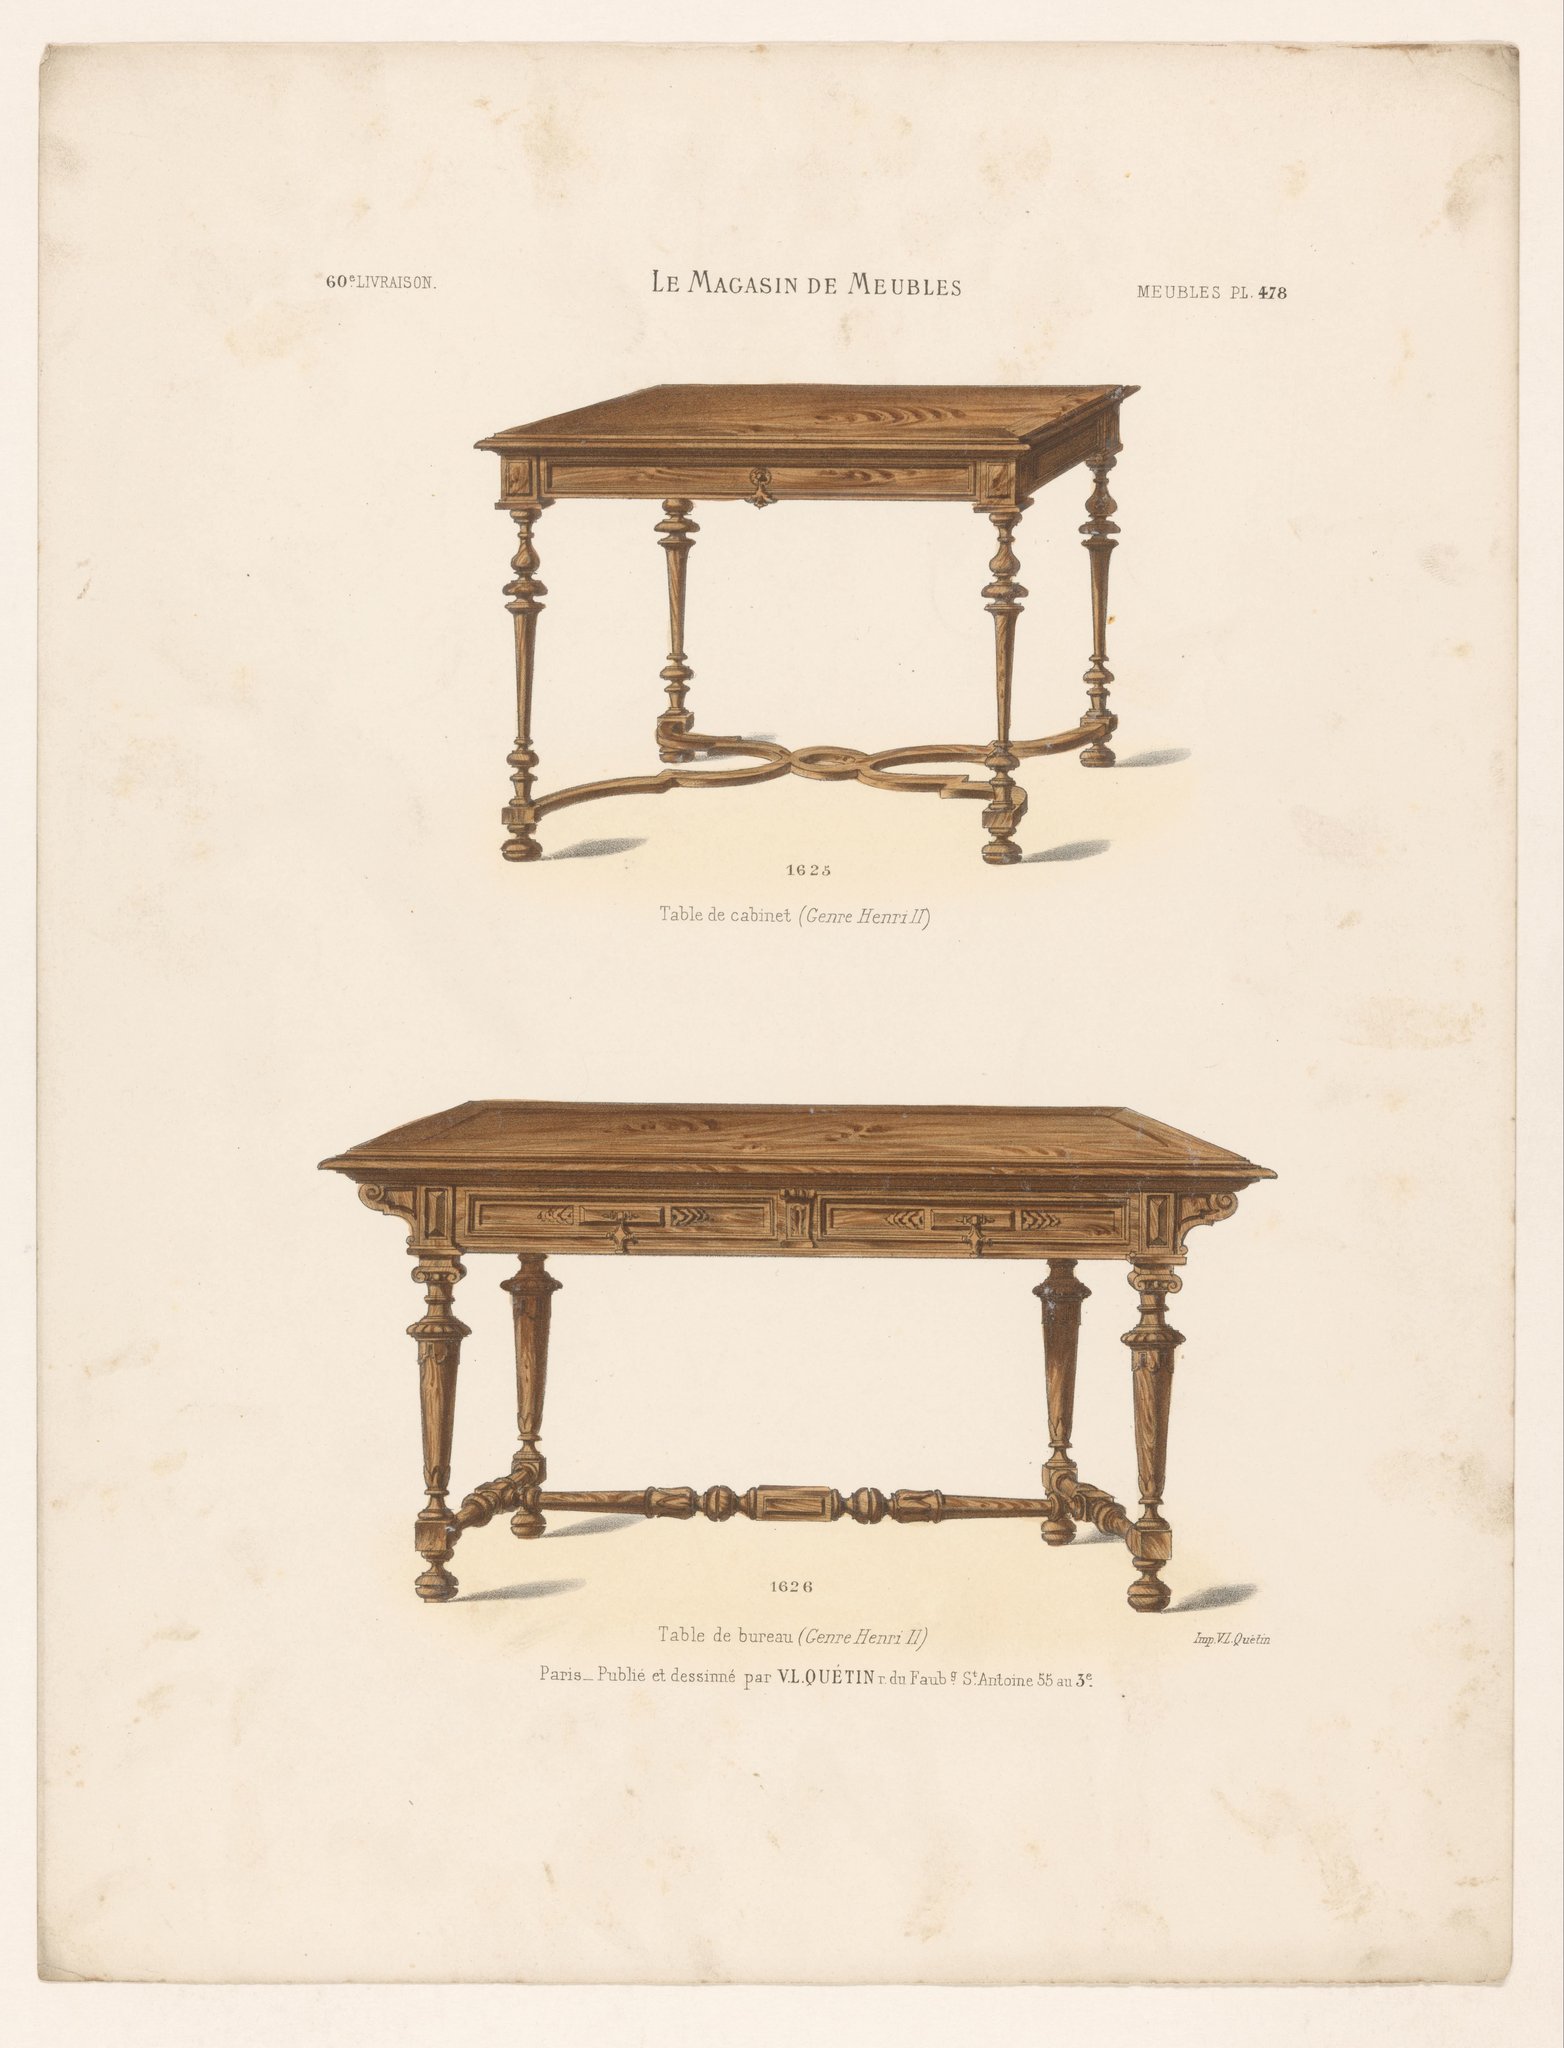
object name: print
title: Table de cabinet (Genre Henri II) / Table de bureau (Genre Henri II)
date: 1878-1904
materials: paper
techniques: hand coloring, lithograph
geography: paris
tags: table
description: Twee tafels in de Hendrik II-stijl. Prent uit 60e Livraison.